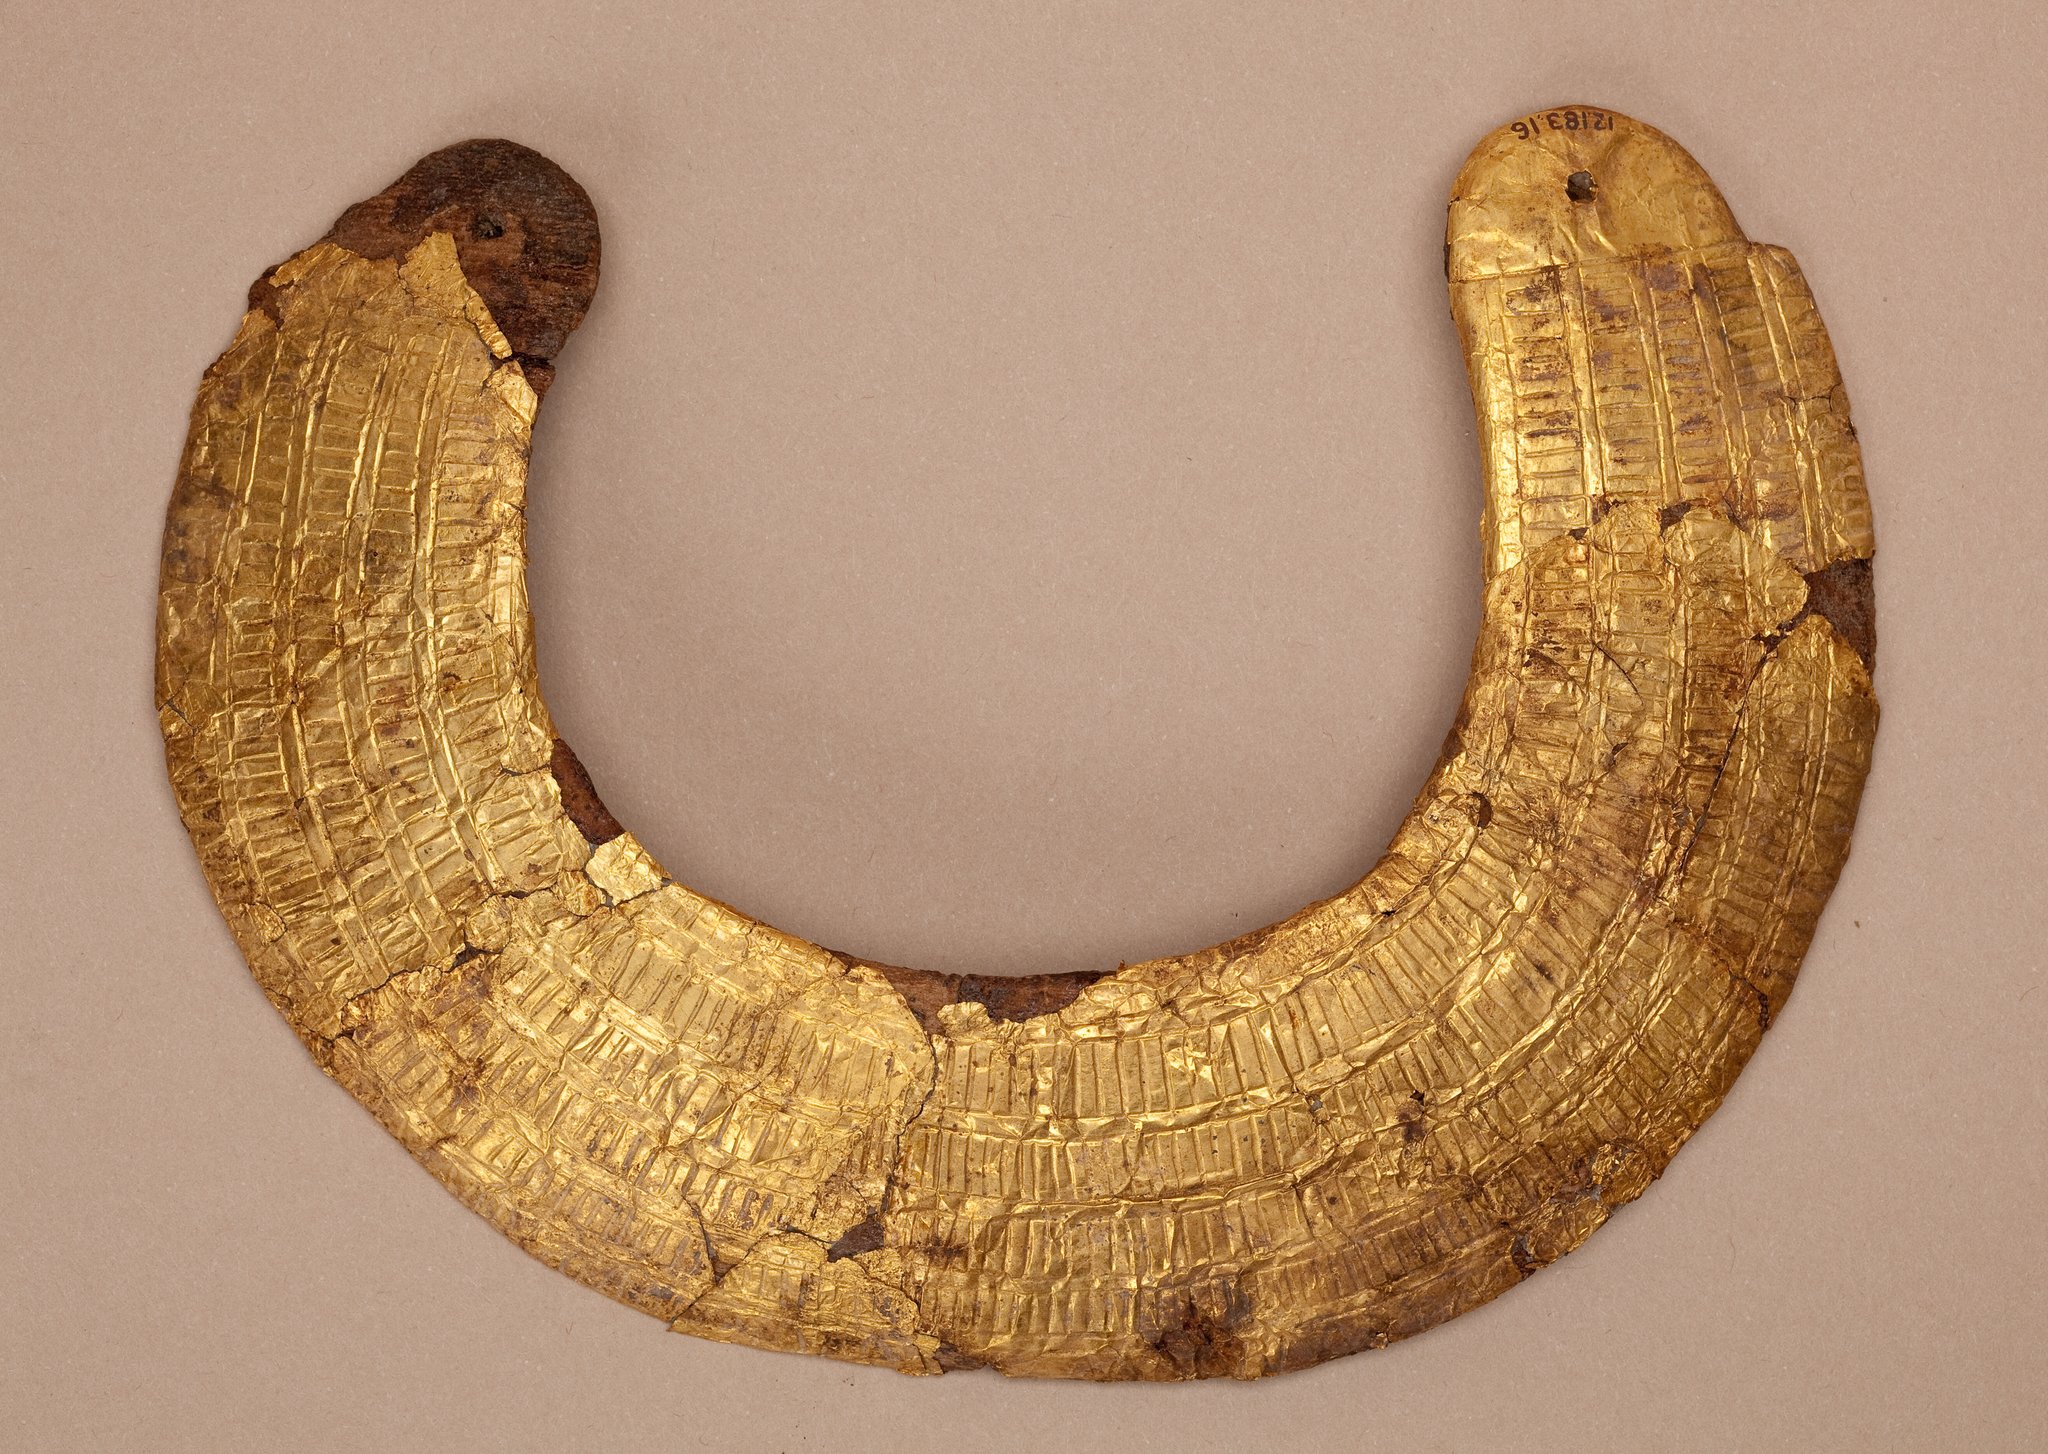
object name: model collar, hapiankhtifi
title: Model collar of Hapiankhtifi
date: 1981-1802 BCE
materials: gesso, gold leaf, textile, wood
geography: egypt